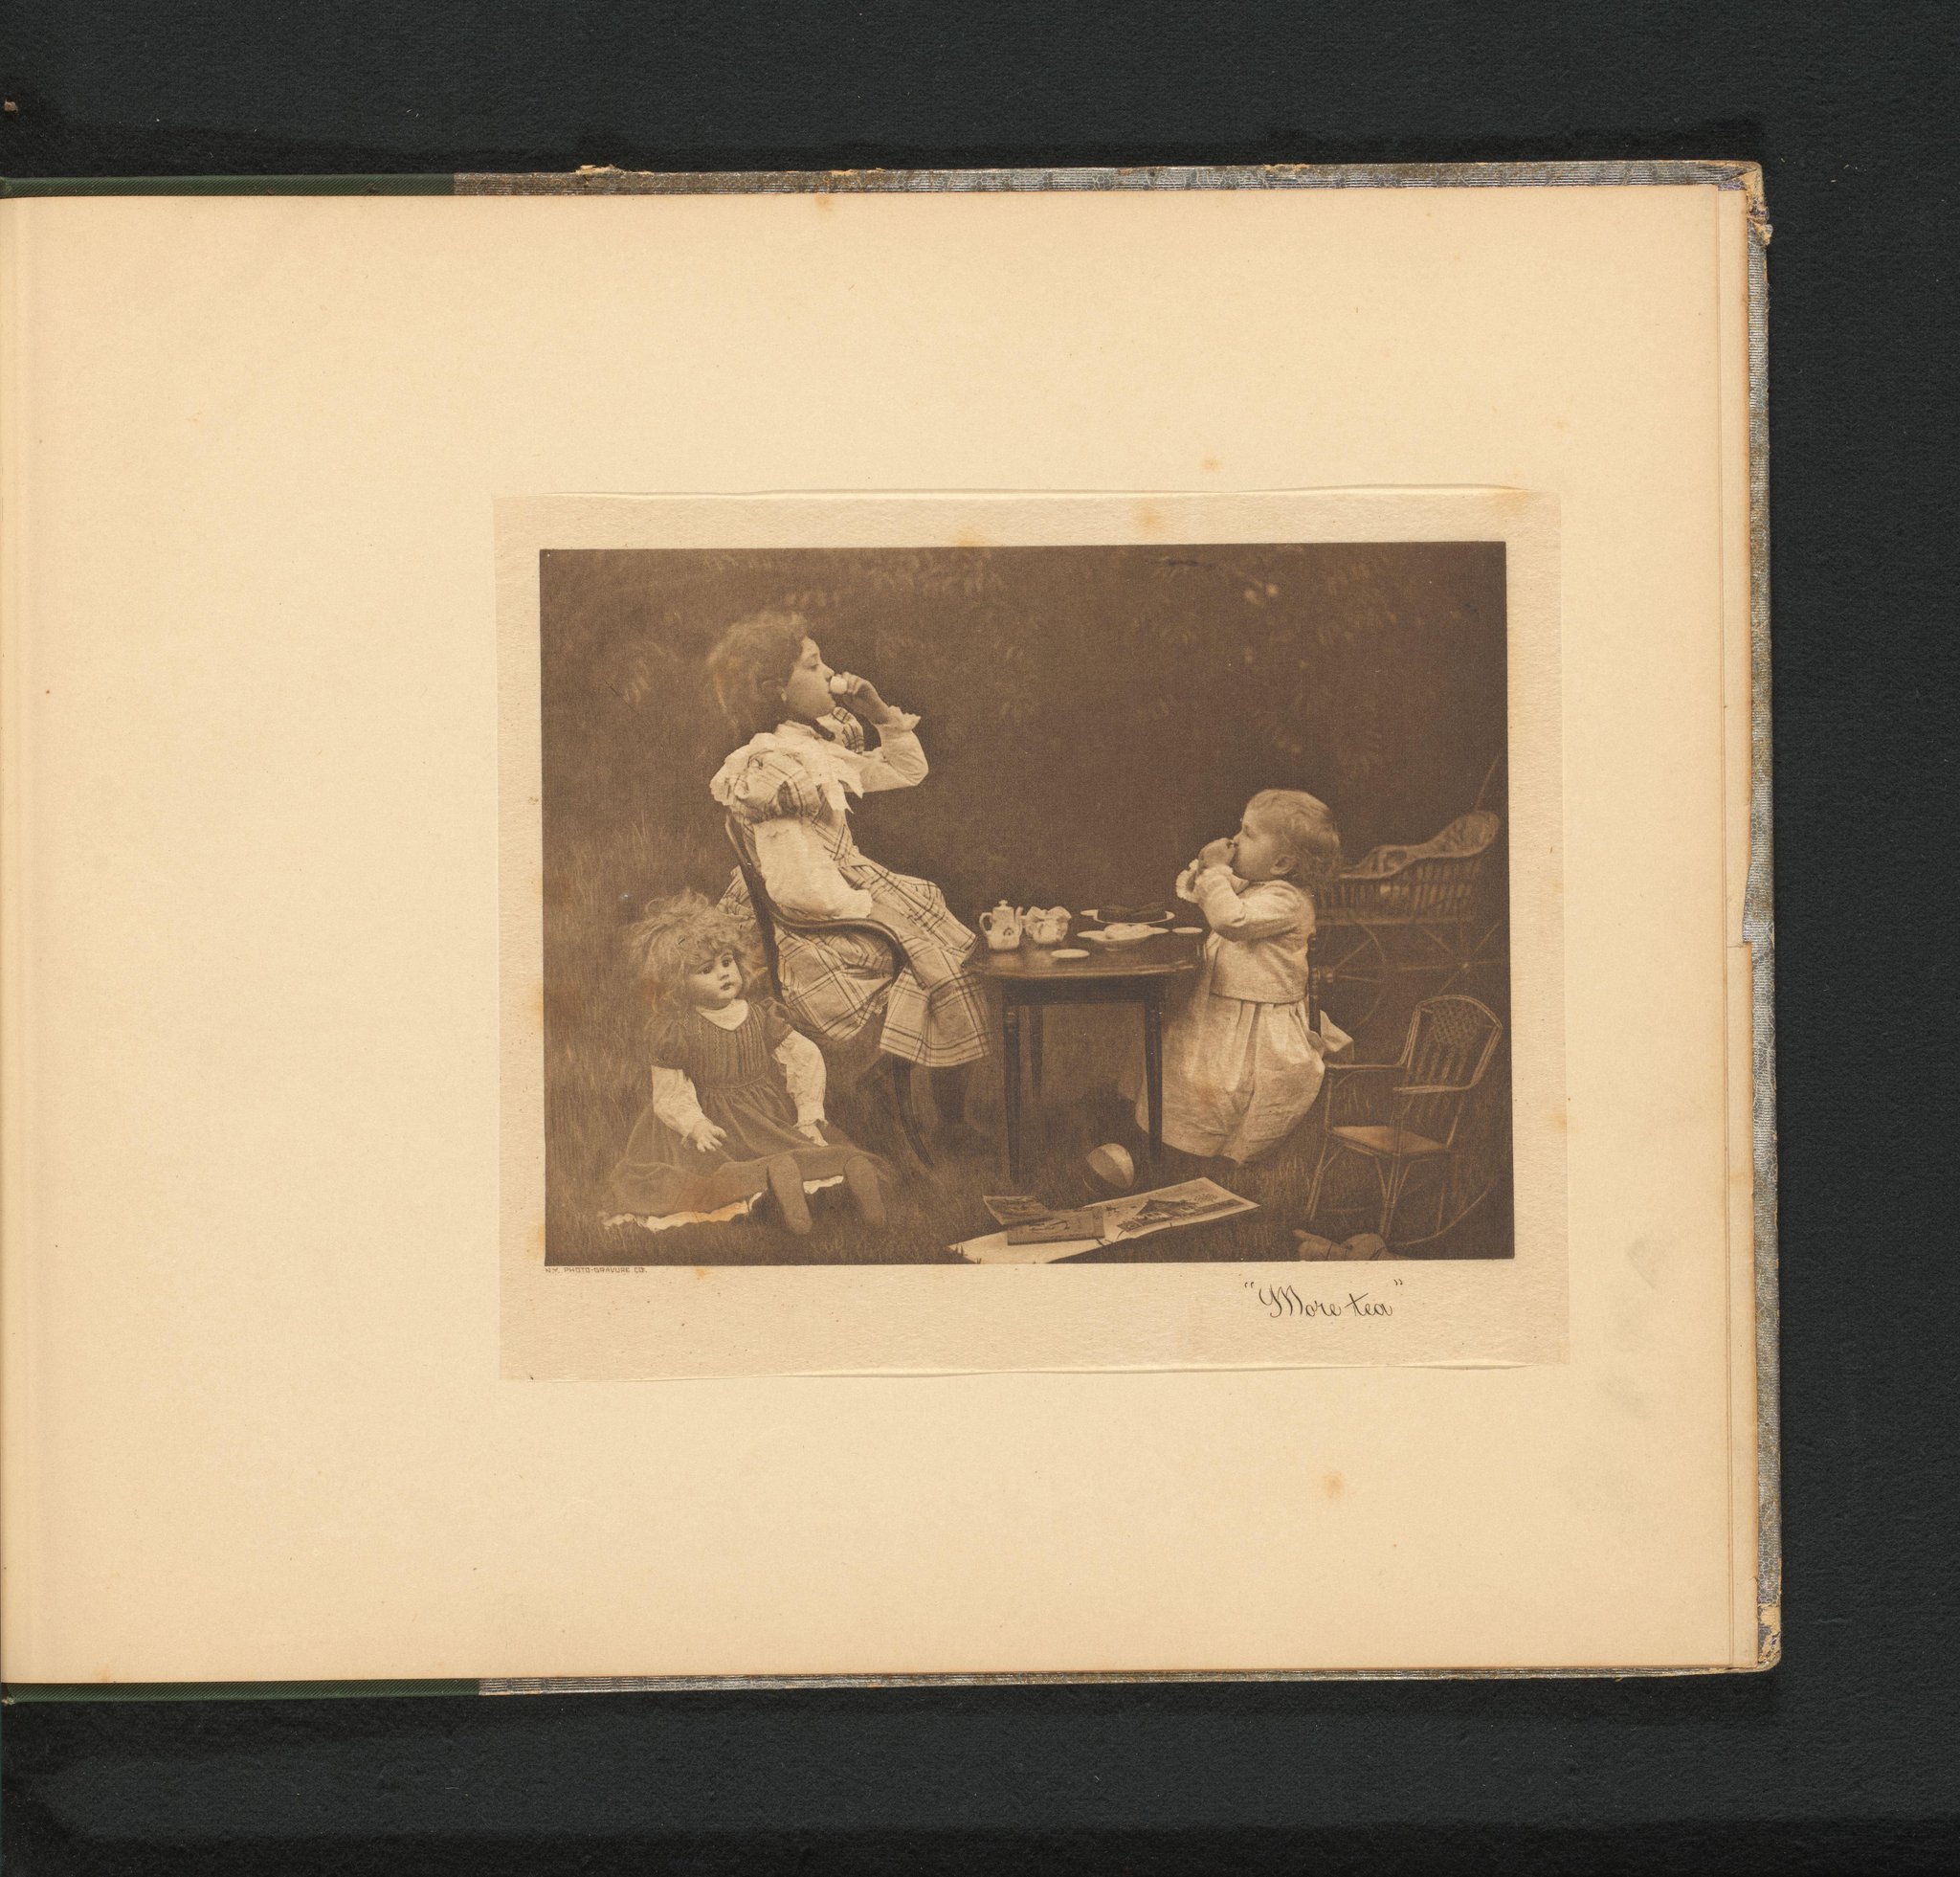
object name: page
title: Twee meisjes die aan een tafel in een tuin thee drinken uit een speelgoed theeservies met daaromheen een poppenwagen, een pop en boeken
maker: walter george mitchell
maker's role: fotograaf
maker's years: 1877-1935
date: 1881-1891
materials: paper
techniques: photoaquatint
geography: new york city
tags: afternoon tea - cc - out of doors, girl (child between toddler and youth), (playing with) dolls